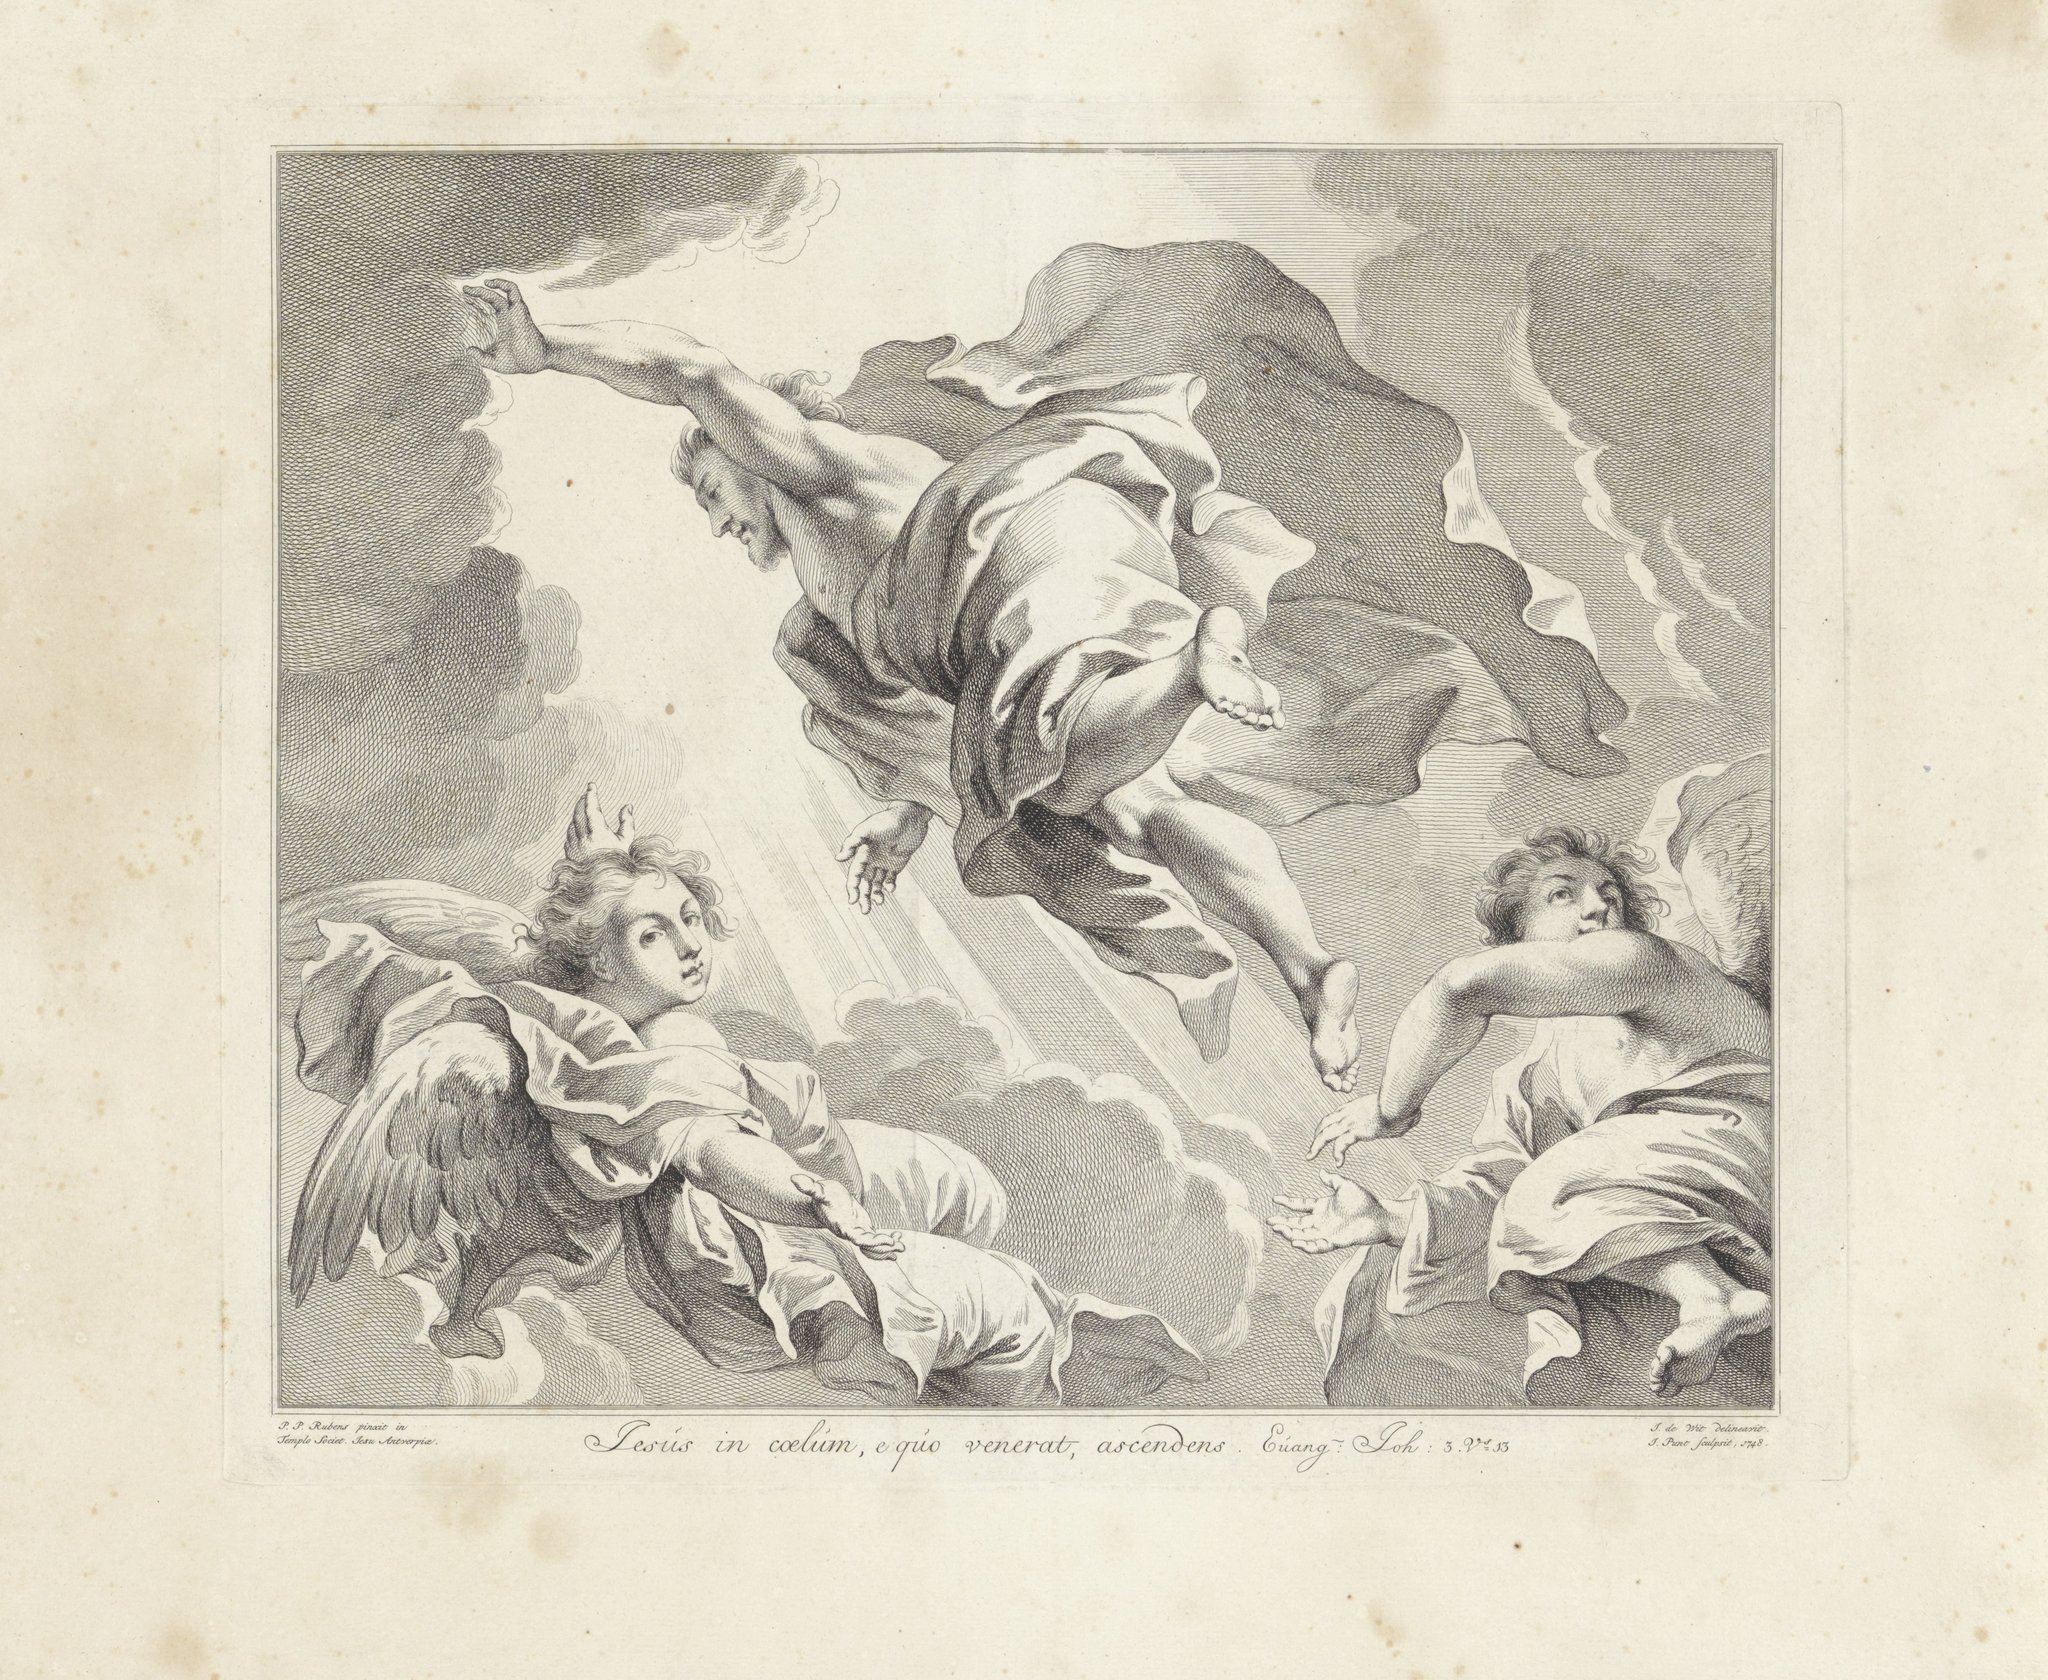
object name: print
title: Hemelvaart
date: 1748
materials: paper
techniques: engraving, etching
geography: amsterdam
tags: christ aloft in the sky ~ ascension (+ angel(s) floating in the air)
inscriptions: collector's mark: Lugt 2228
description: Christus stijgt ten hemel gevolgd door twee engelen. Onder de rechthoekige voorstelling een vers in het Latijn uit Joh. 2:13.